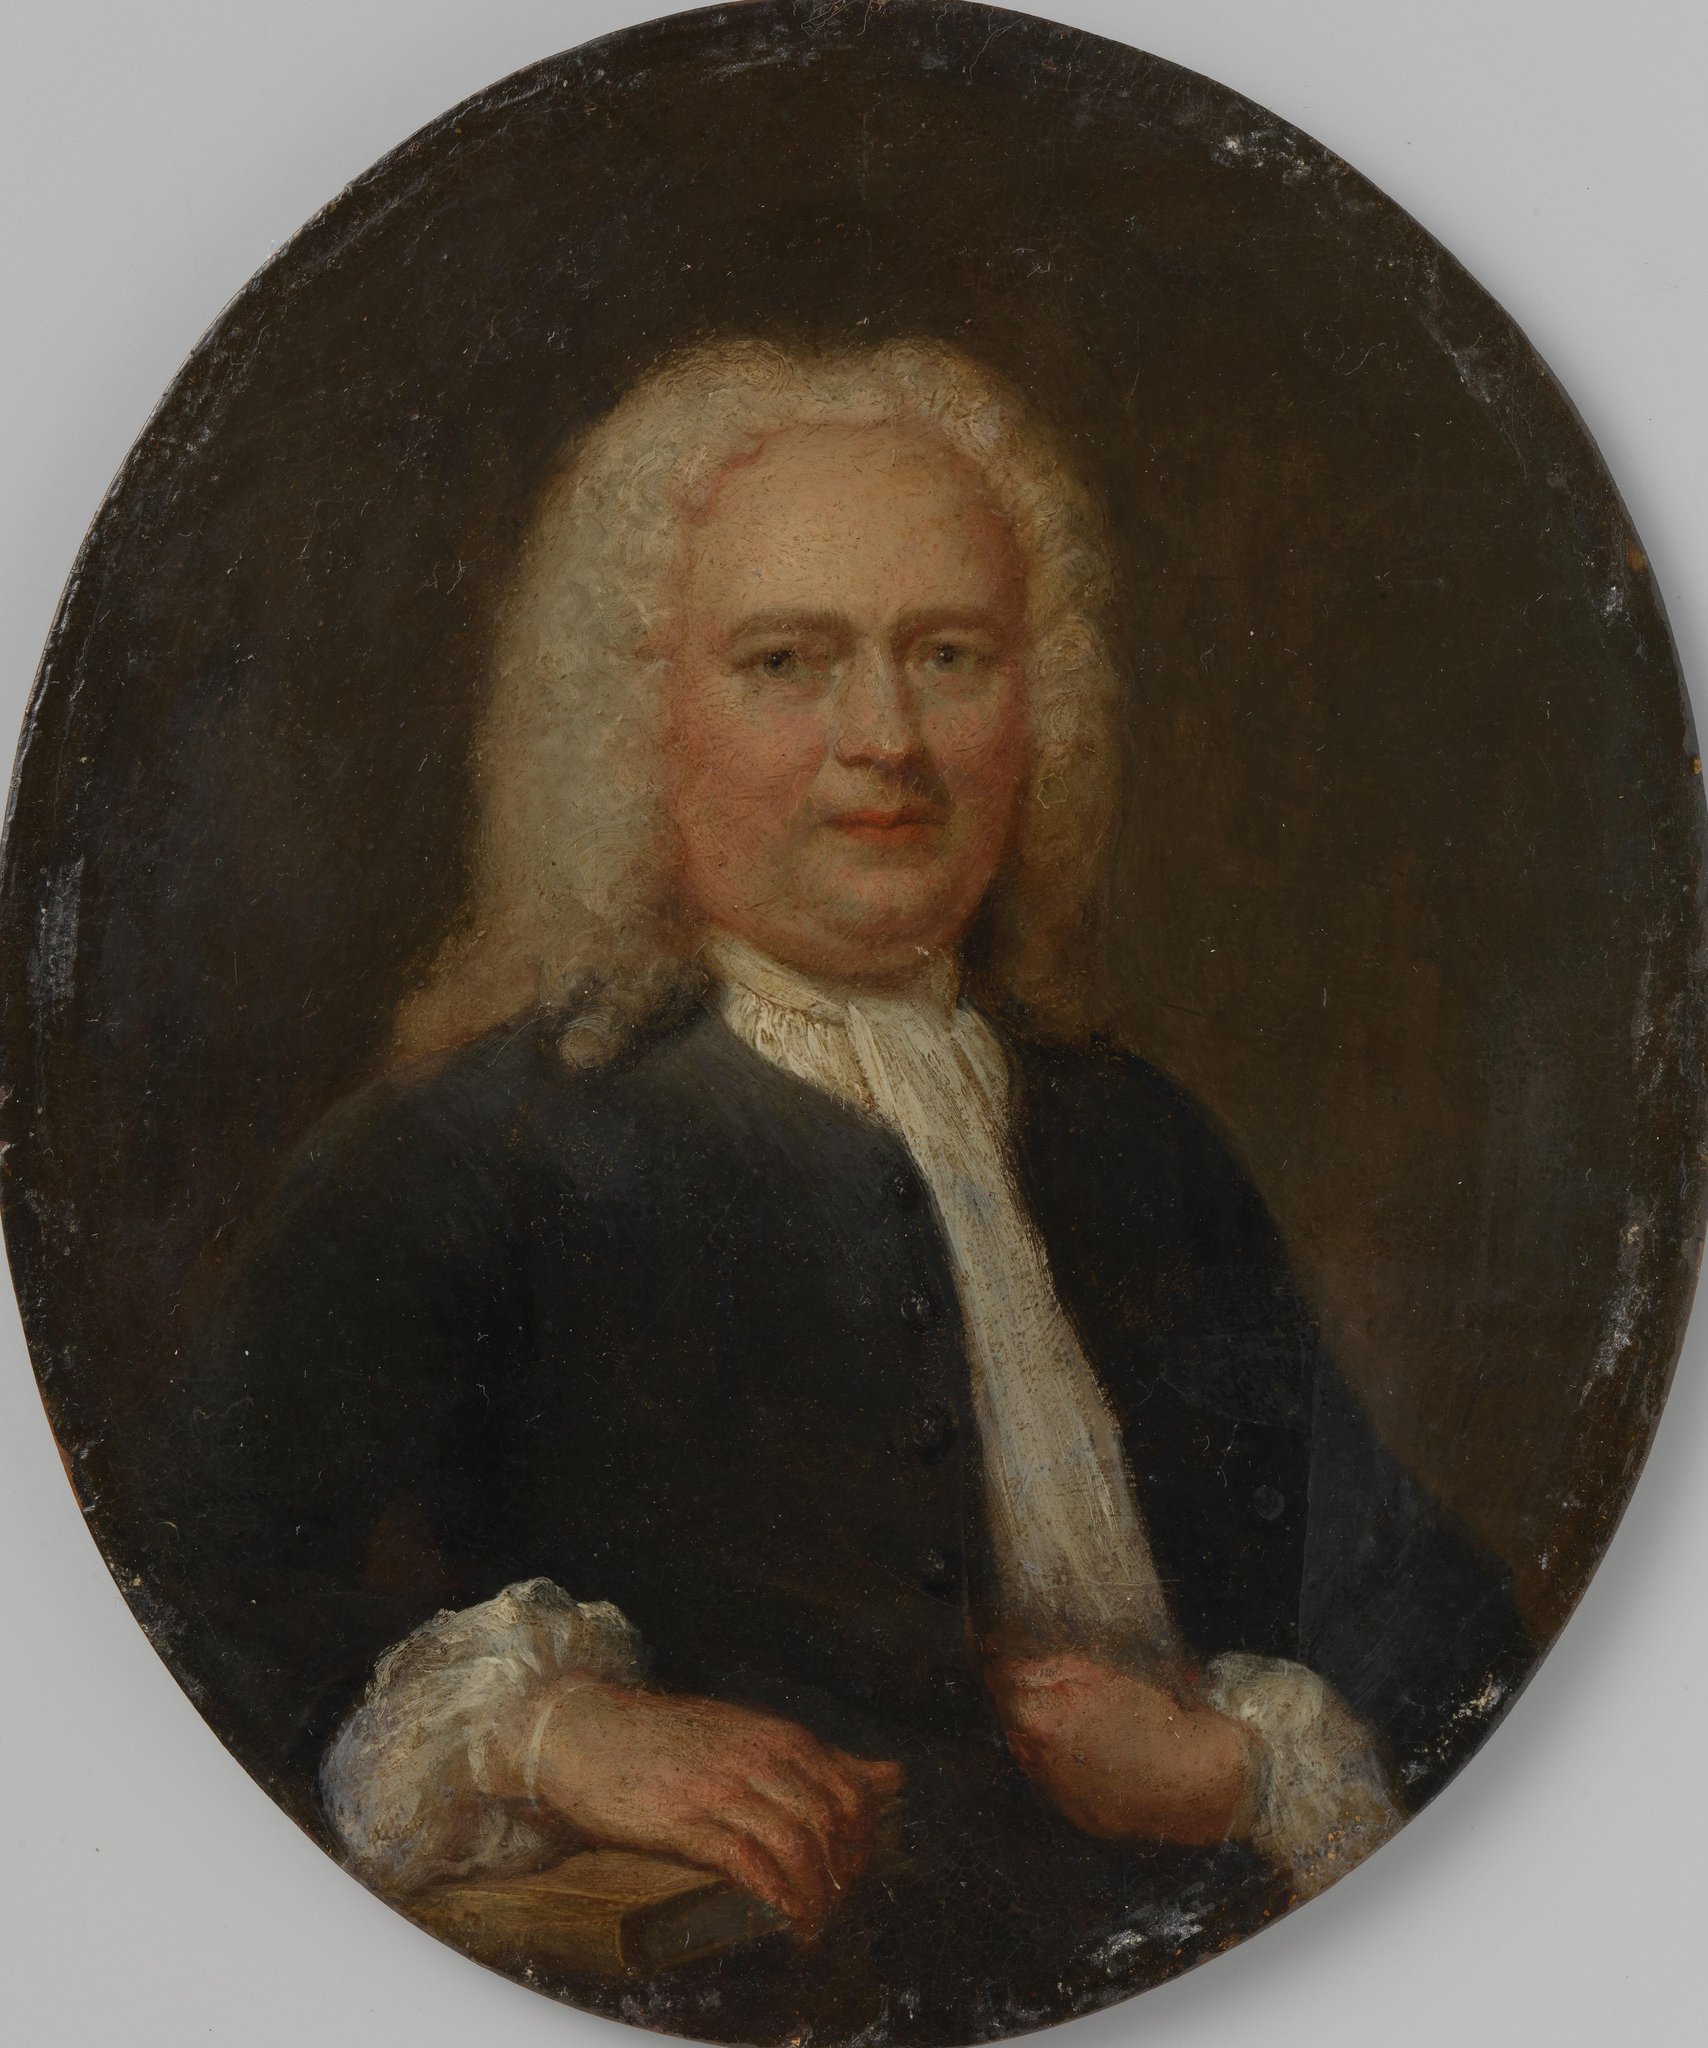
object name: painting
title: Portrait of a Man, perhaps a Member of the Klinkhamer Family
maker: jan maurits quinkhard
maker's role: draughtsman, painter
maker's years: 1688-1772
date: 1738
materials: copper, oil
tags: historical persons not known by name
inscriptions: signature and date: ‘J.M. Quinkhard pinxit 1738. AEt: 46’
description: Portret van een man, misschien een lid van de familie Klinkhamer. Ten halven lijve, zittend naast een tafel, de rechterhand op een boek.